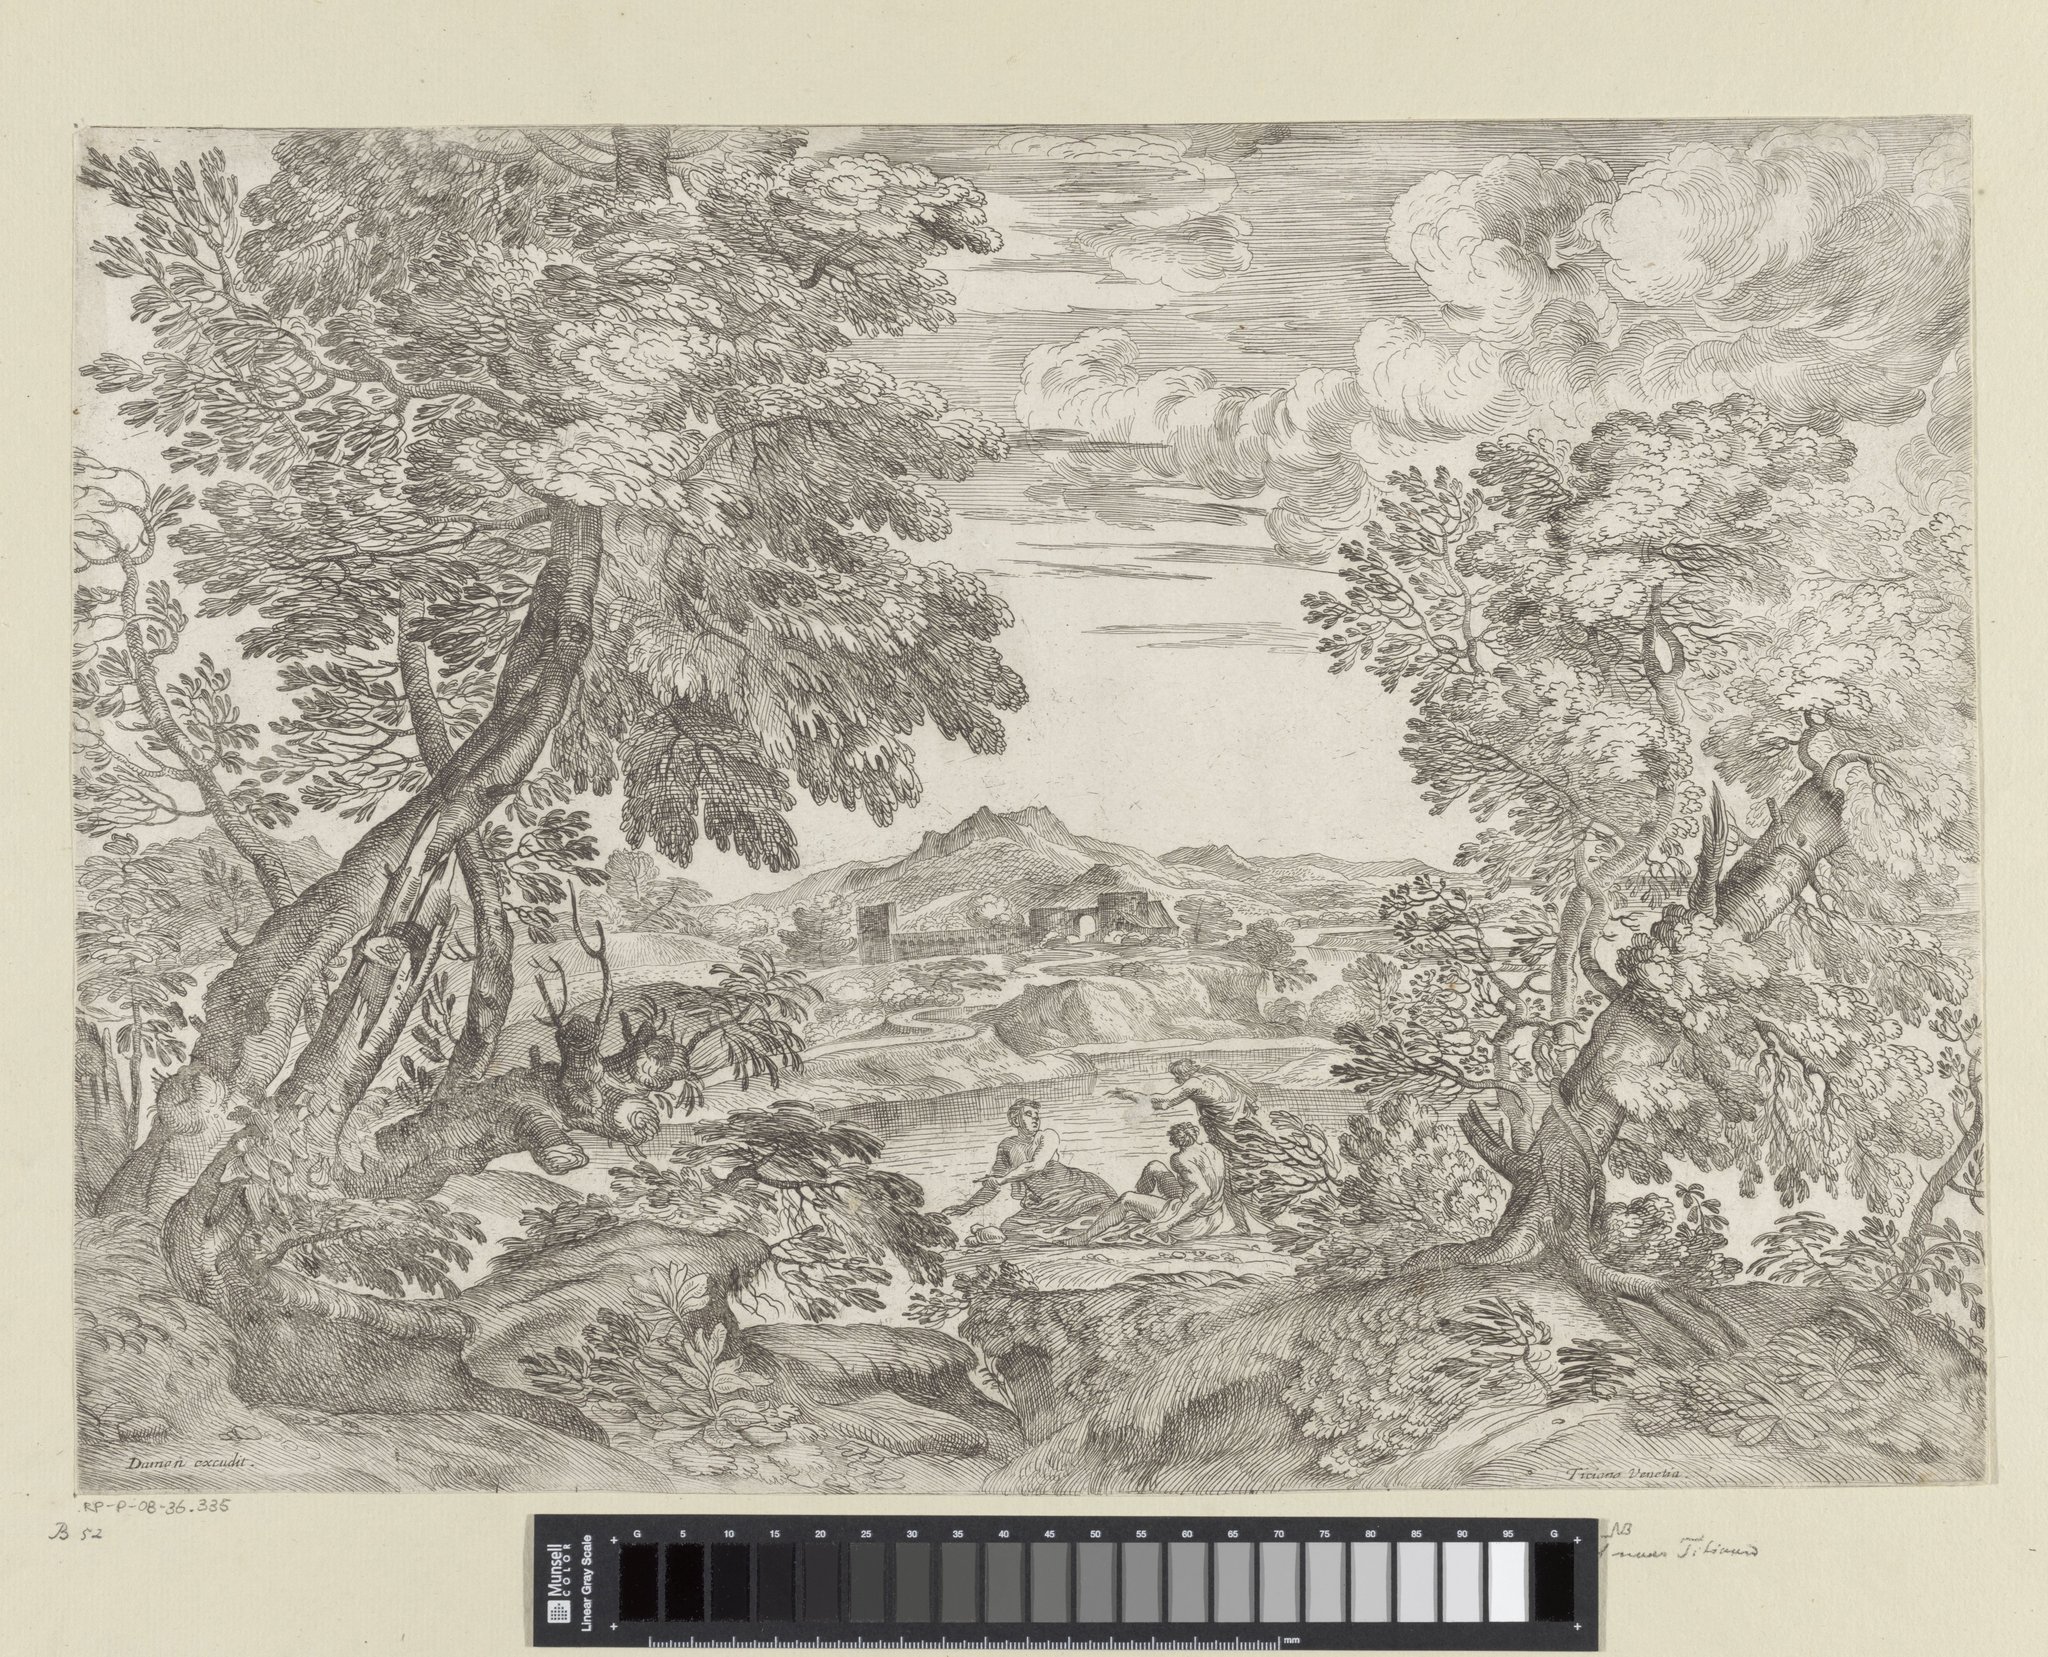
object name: print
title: Landschap met drie mannen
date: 1616-1680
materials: paper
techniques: etching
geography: venice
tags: landscapes, lake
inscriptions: collector's mark: Lugt 240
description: Landschap met drie mannen aan de rand van een meer.